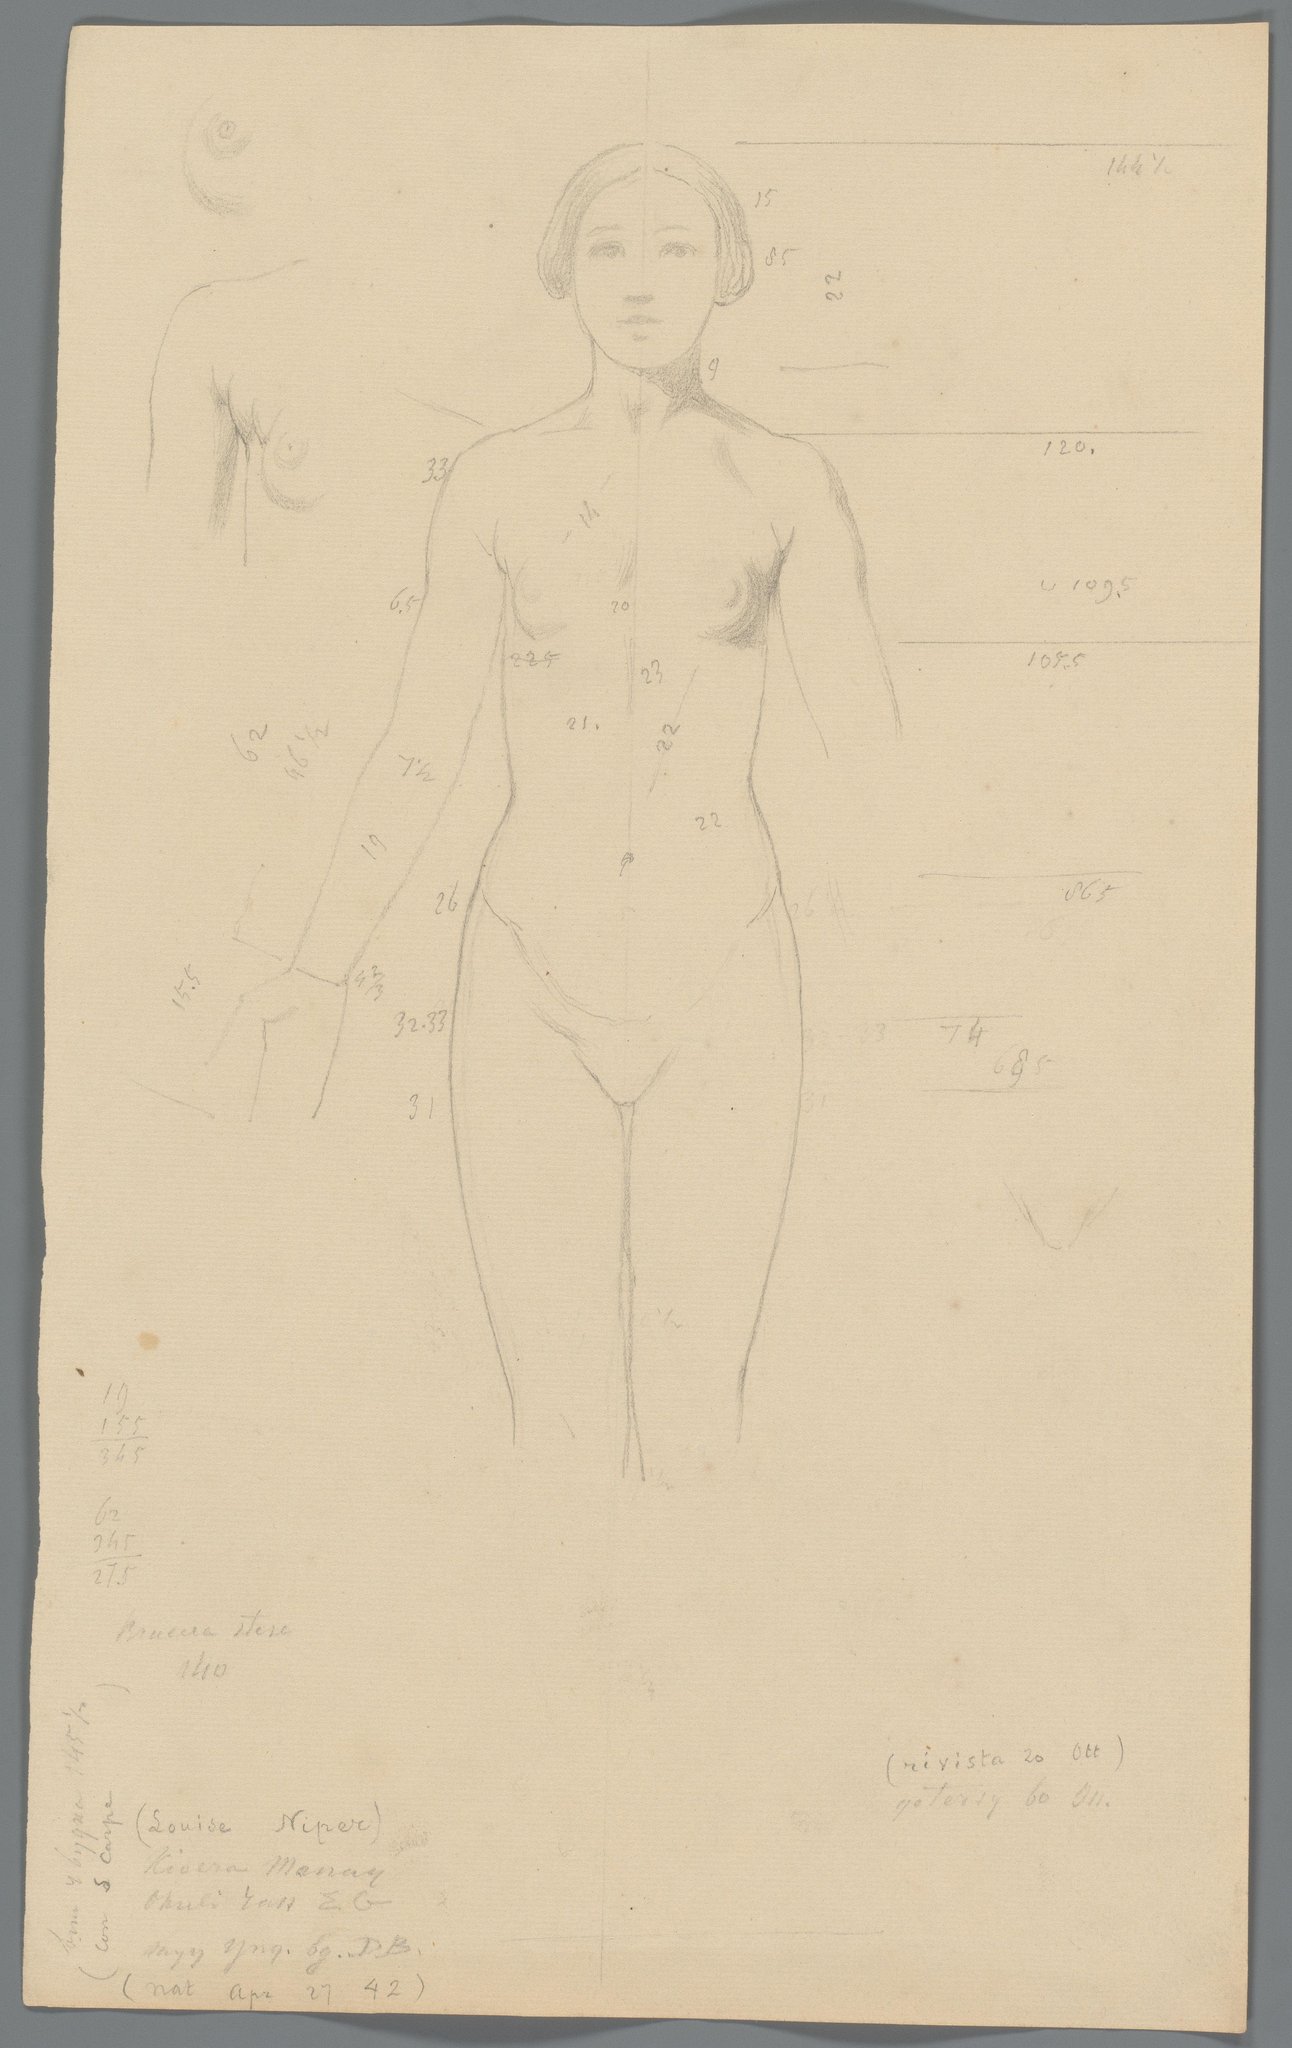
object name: drawing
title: Proportiestudie van een vrouw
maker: jacobus everhardus josephus van den berg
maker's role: draughtsman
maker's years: 1802-1861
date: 1857-1861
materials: paper, pencil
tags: standing figure (canon, proportions) - aa - female human figure, anatomy (non-medical) - aa - female human figure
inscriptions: inscription: ‘Louise Niper (...) nat Apr 27 42’